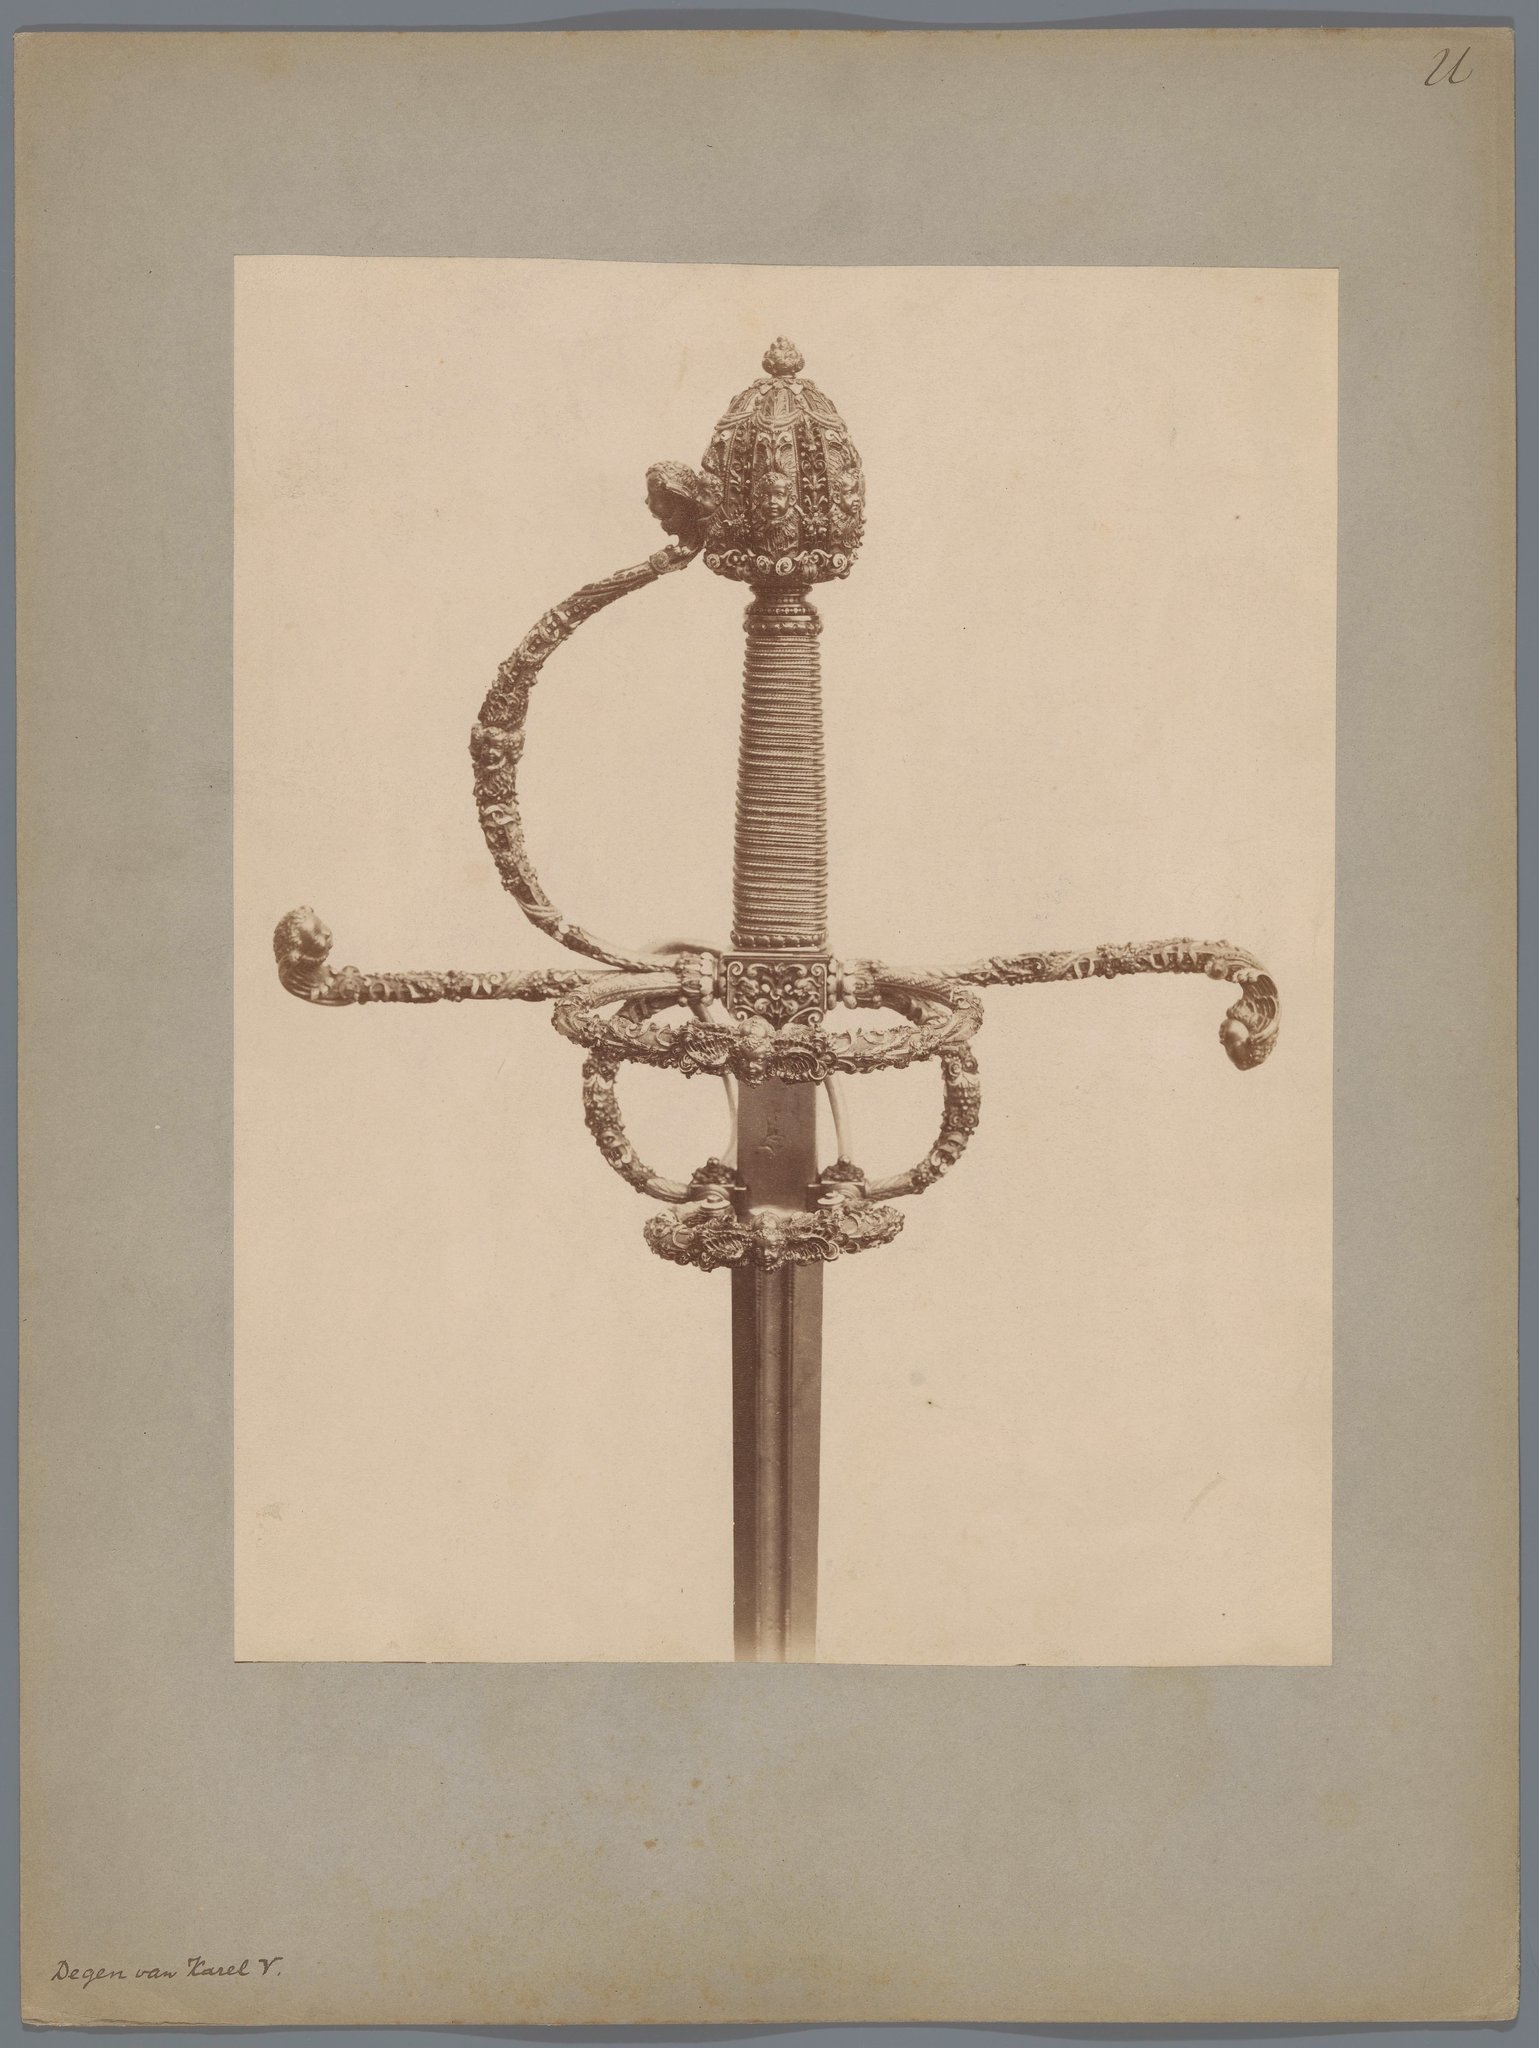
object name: photograph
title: Gedecoreerde handgreep van de degen van Keizer Karel V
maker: Anonymous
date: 1850-1900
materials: cardboard, photographic support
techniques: albumen print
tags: weapons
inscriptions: inscription: ‘U’, inscription: ‘Prachtdegen/ van Keizer Karel V/ goud [...]’, inscription: ‘Degen van Karel V.’, collector's mark: ‘Rijks normaalschool voor teekenonderwijzers Amsterdam’